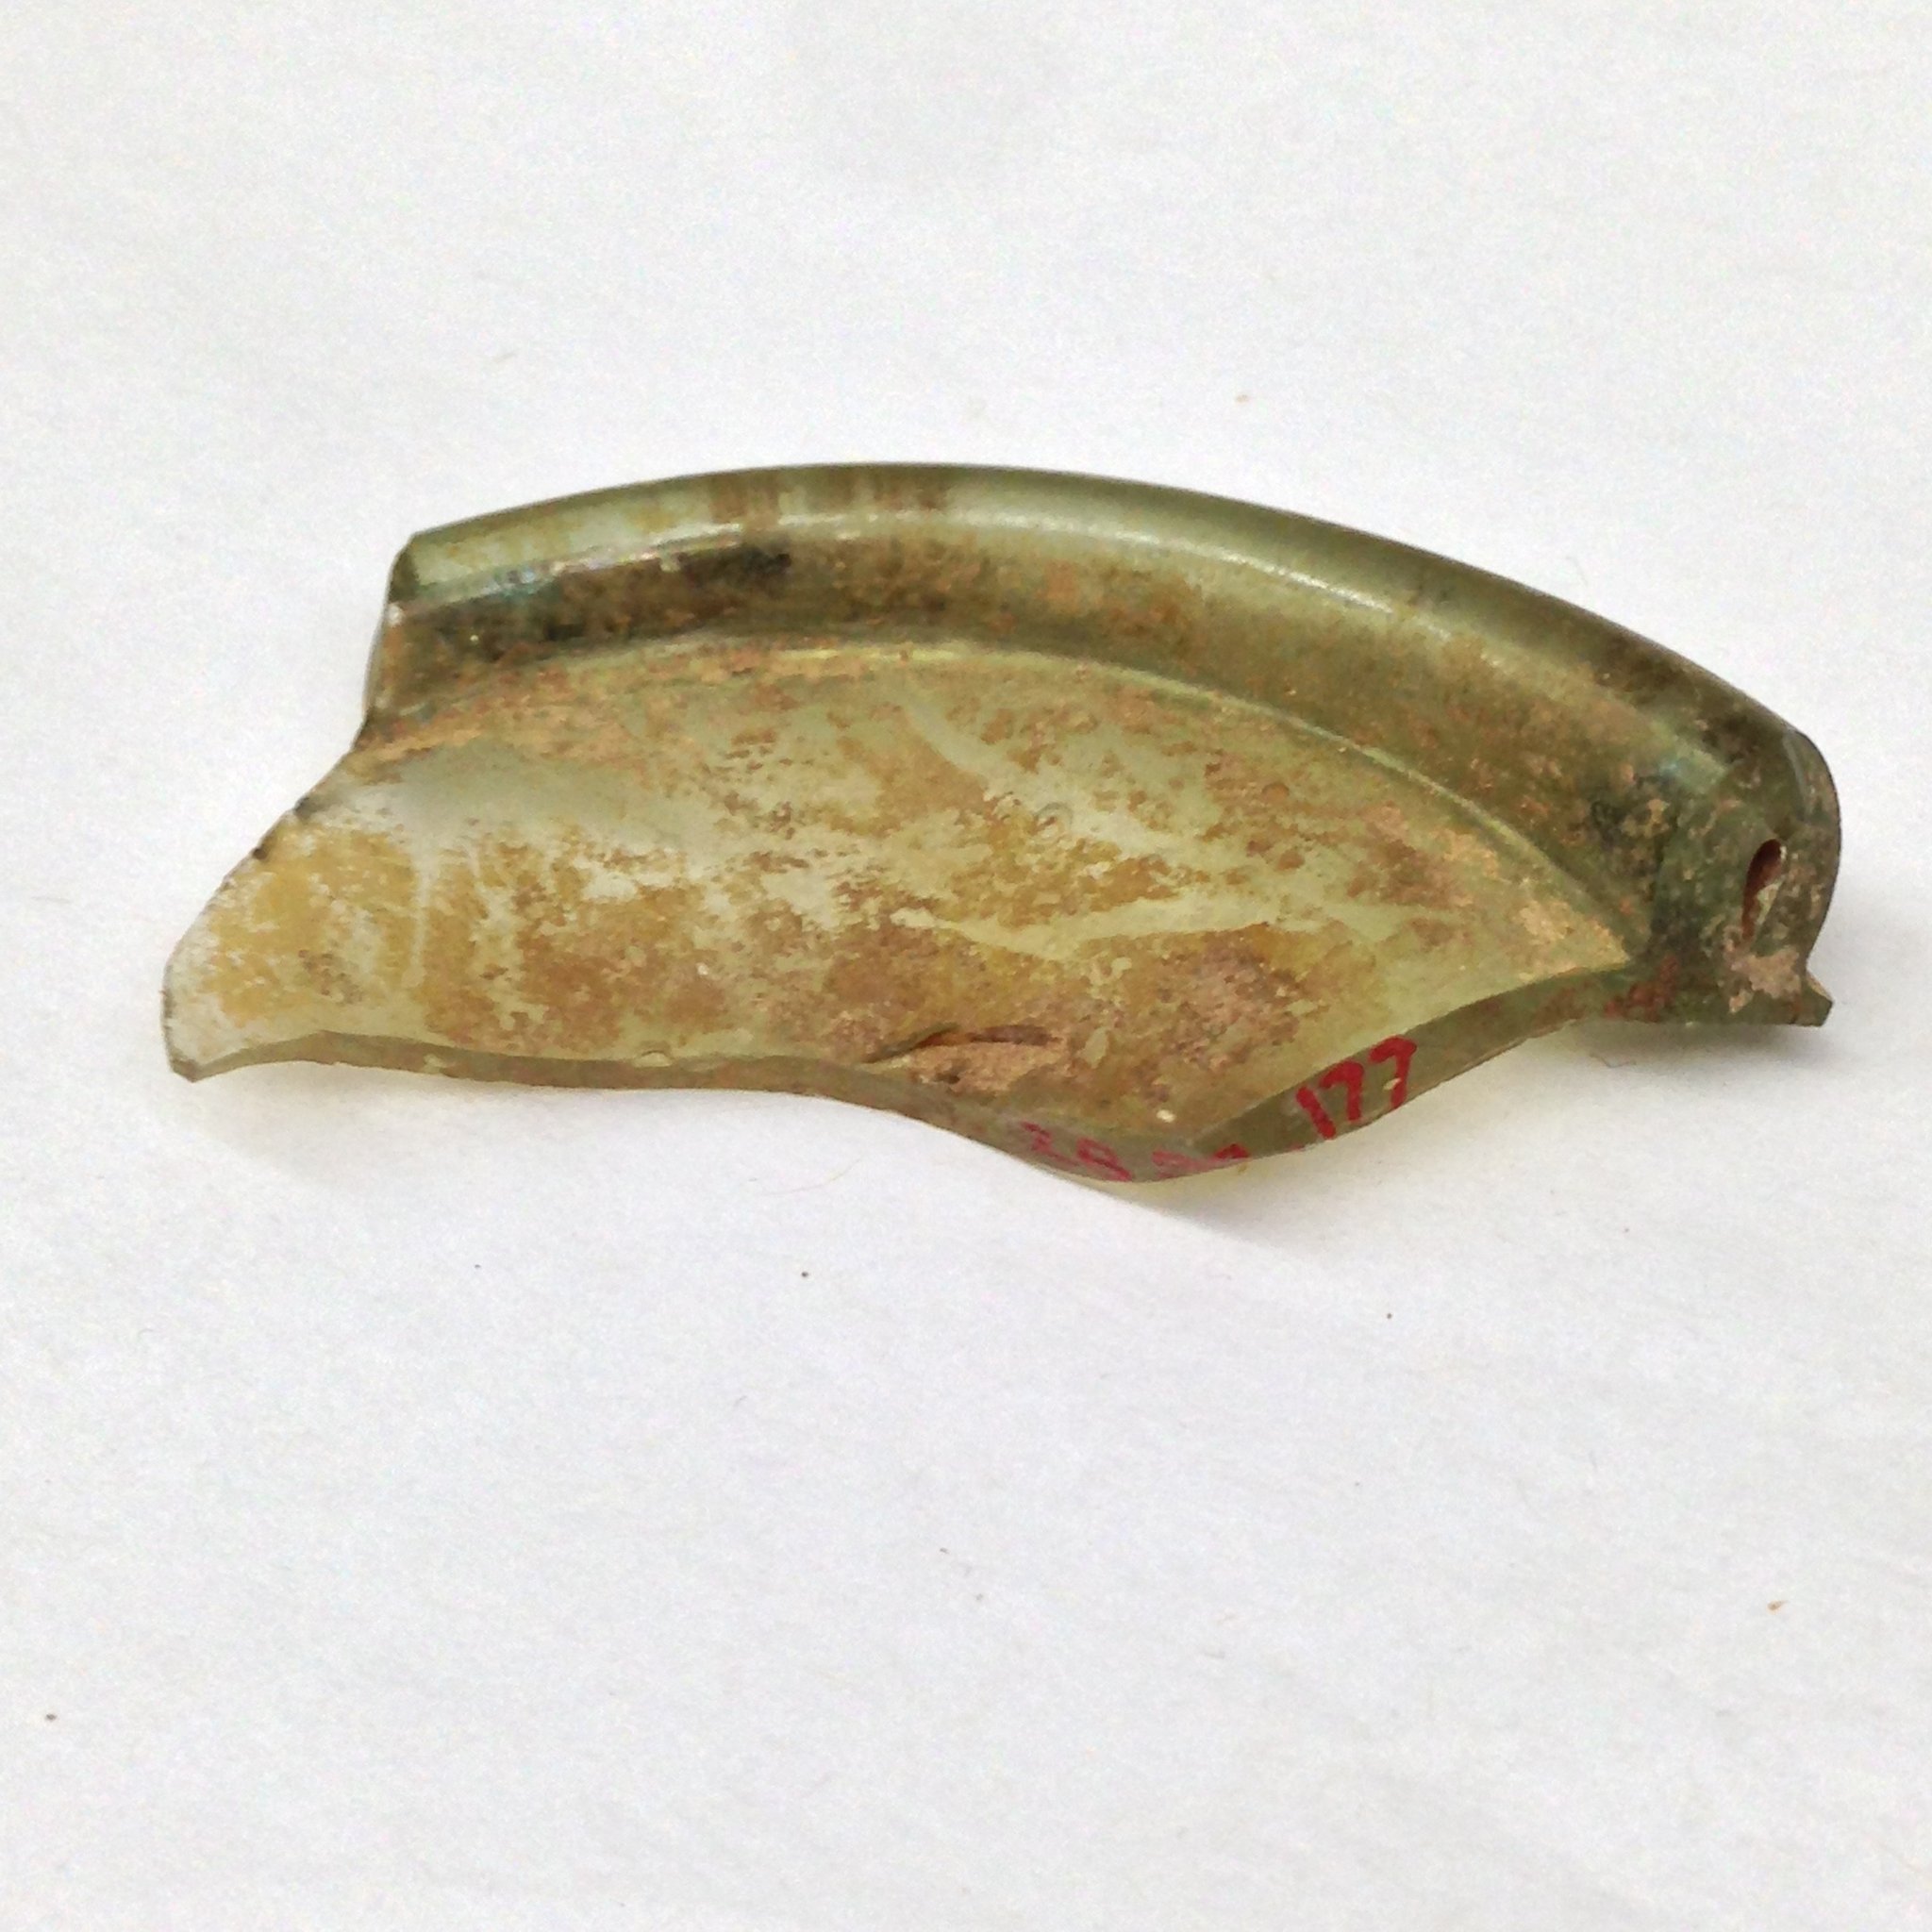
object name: fragment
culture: european or middle eastern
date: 1150-1250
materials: ceramic, glass